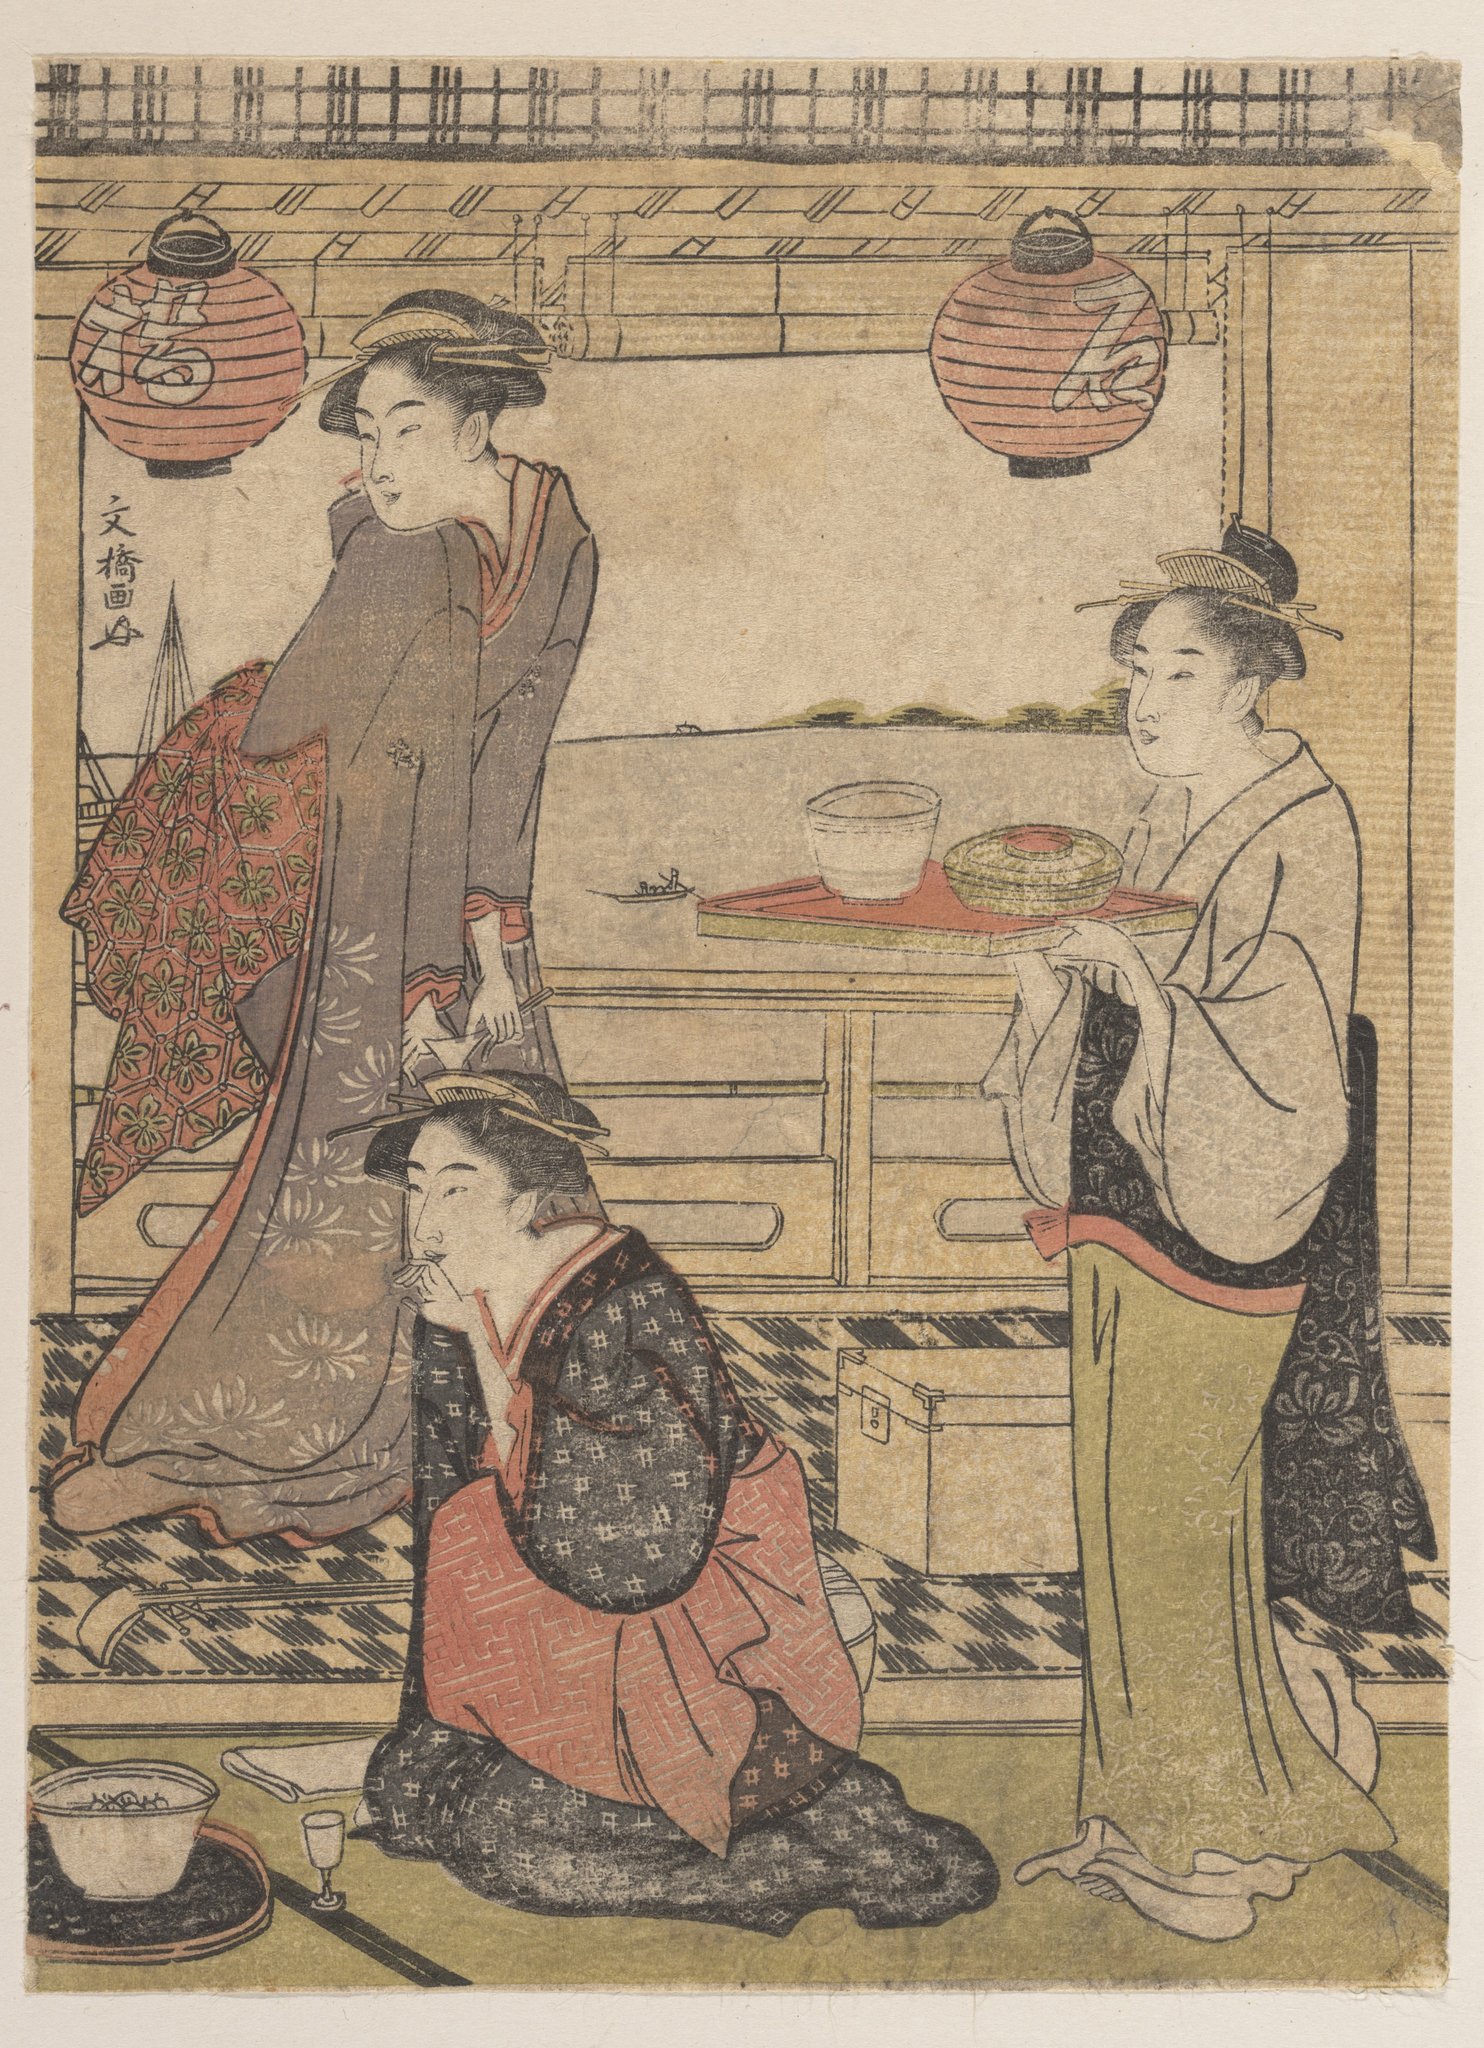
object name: print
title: An Entertainment at Shinagawa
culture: japanese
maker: sakuragawa bunkyo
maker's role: artist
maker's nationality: japanese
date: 1788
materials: ink, paper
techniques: woodblock print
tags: women,smoking